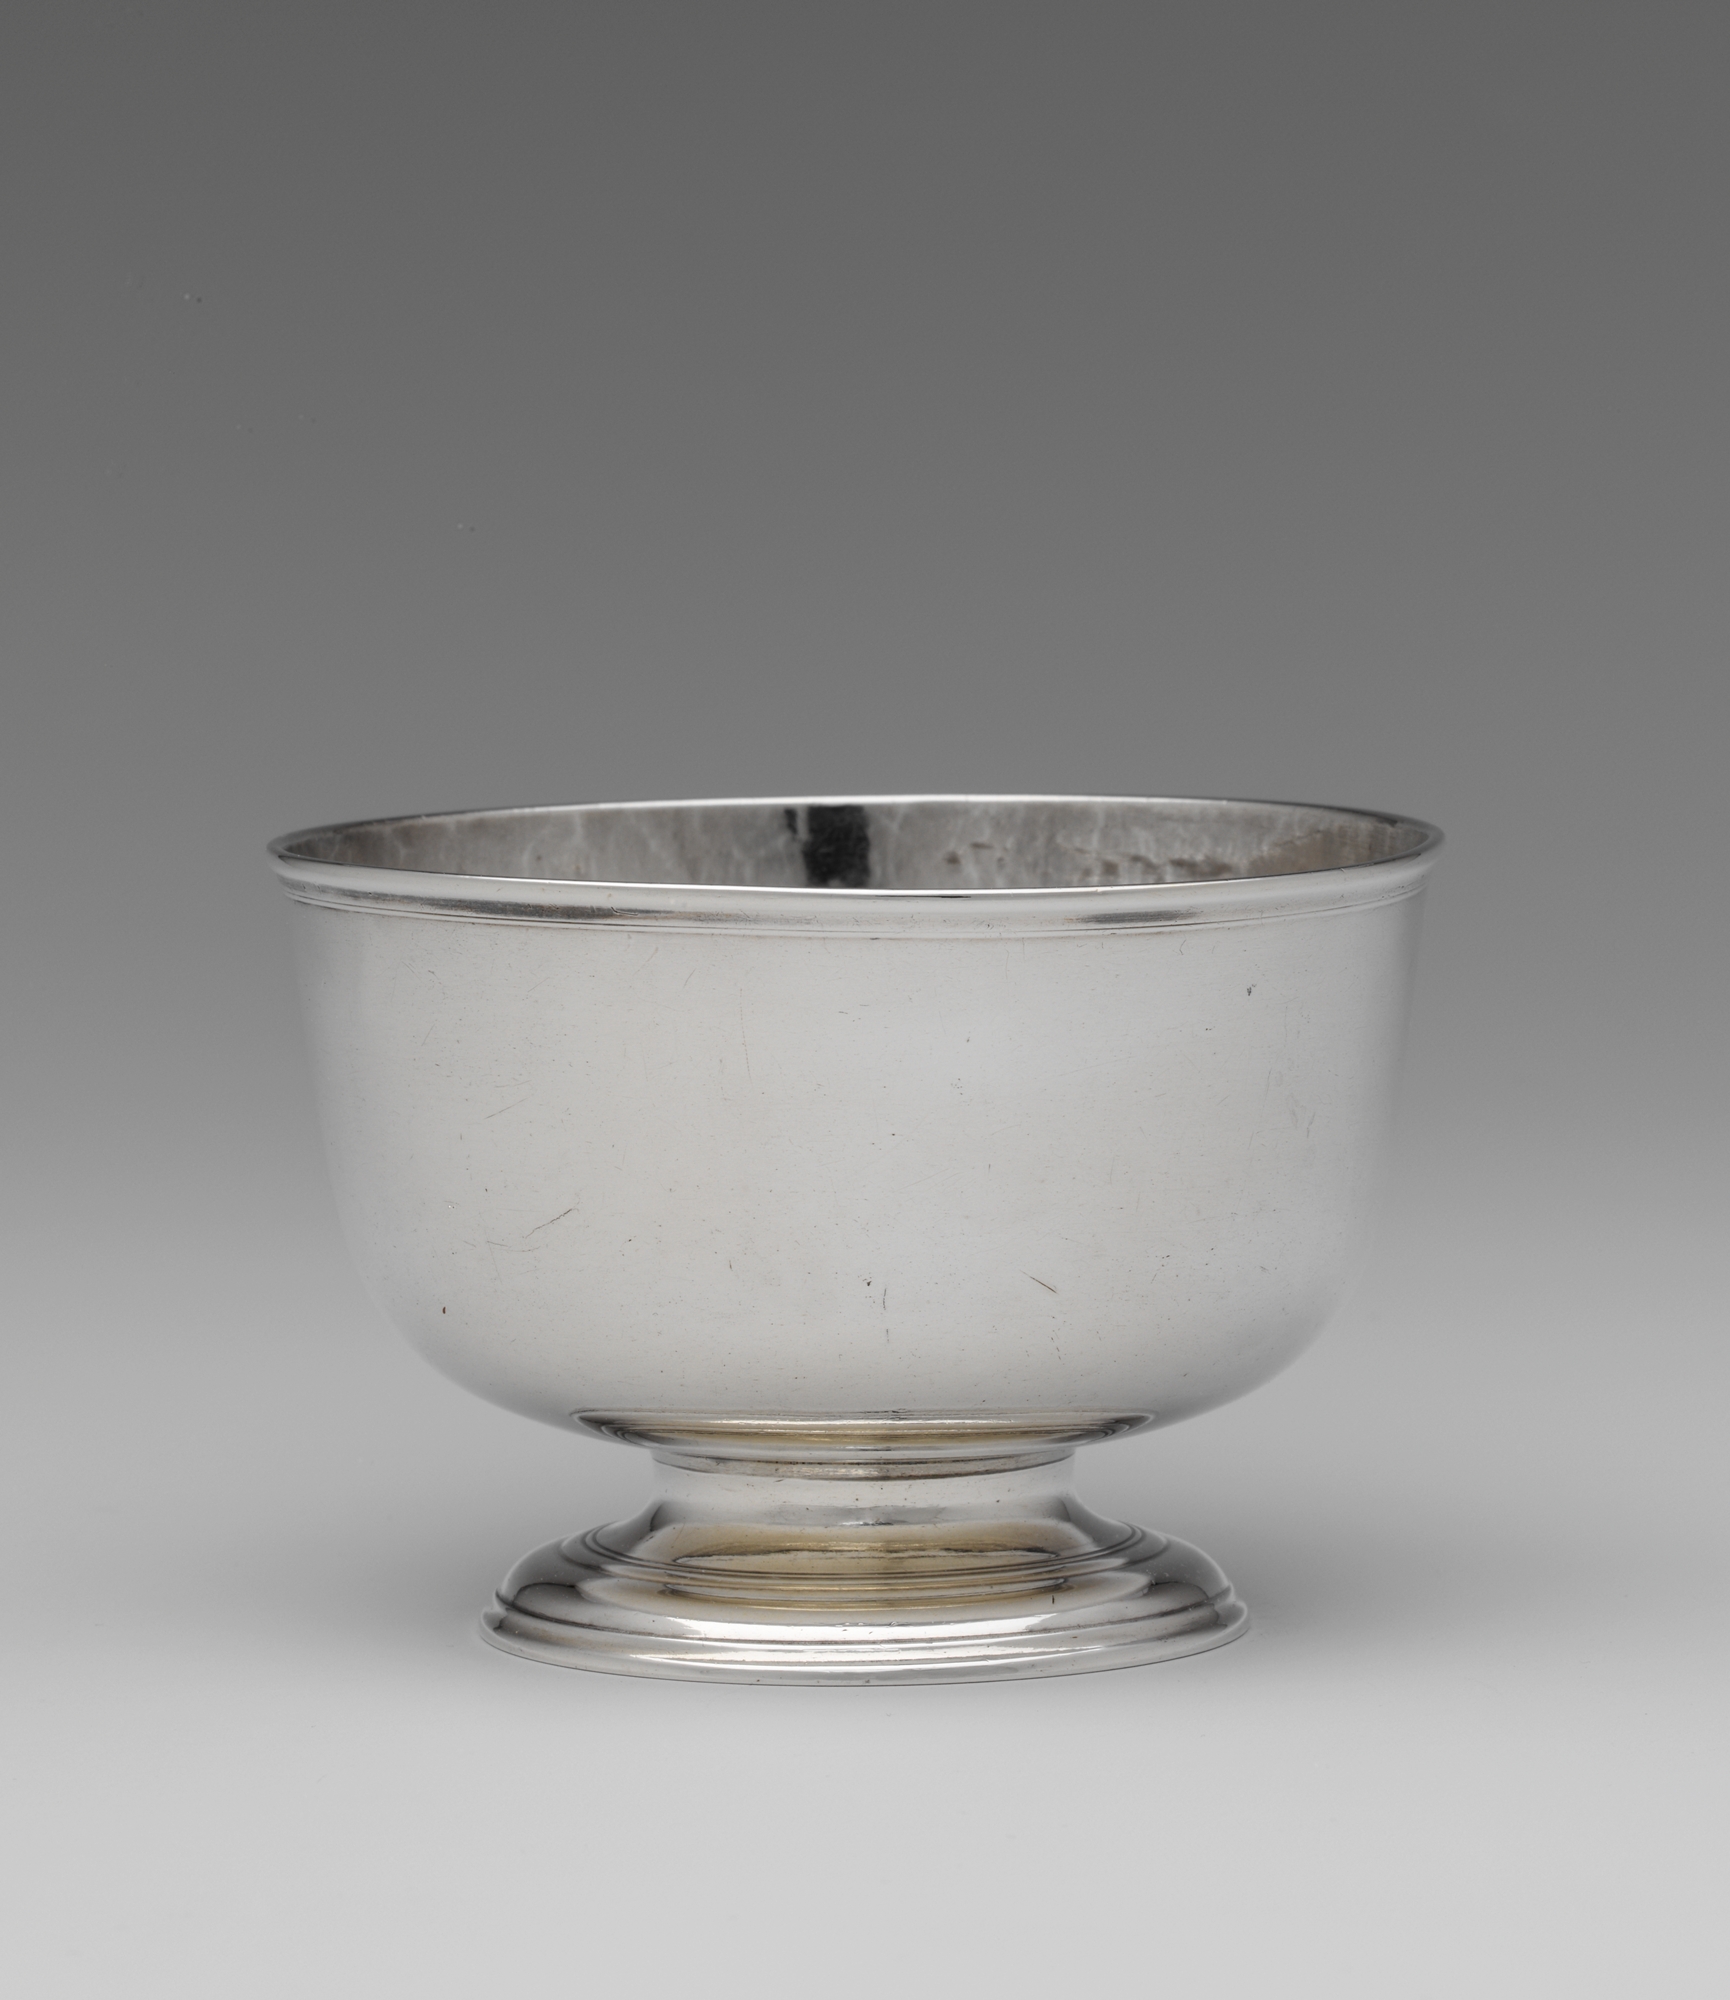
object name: sugar bowl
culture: american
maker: philip syng jr.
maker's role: maker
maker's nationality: american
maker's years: 1703-1789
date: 1760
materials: silver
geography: united states